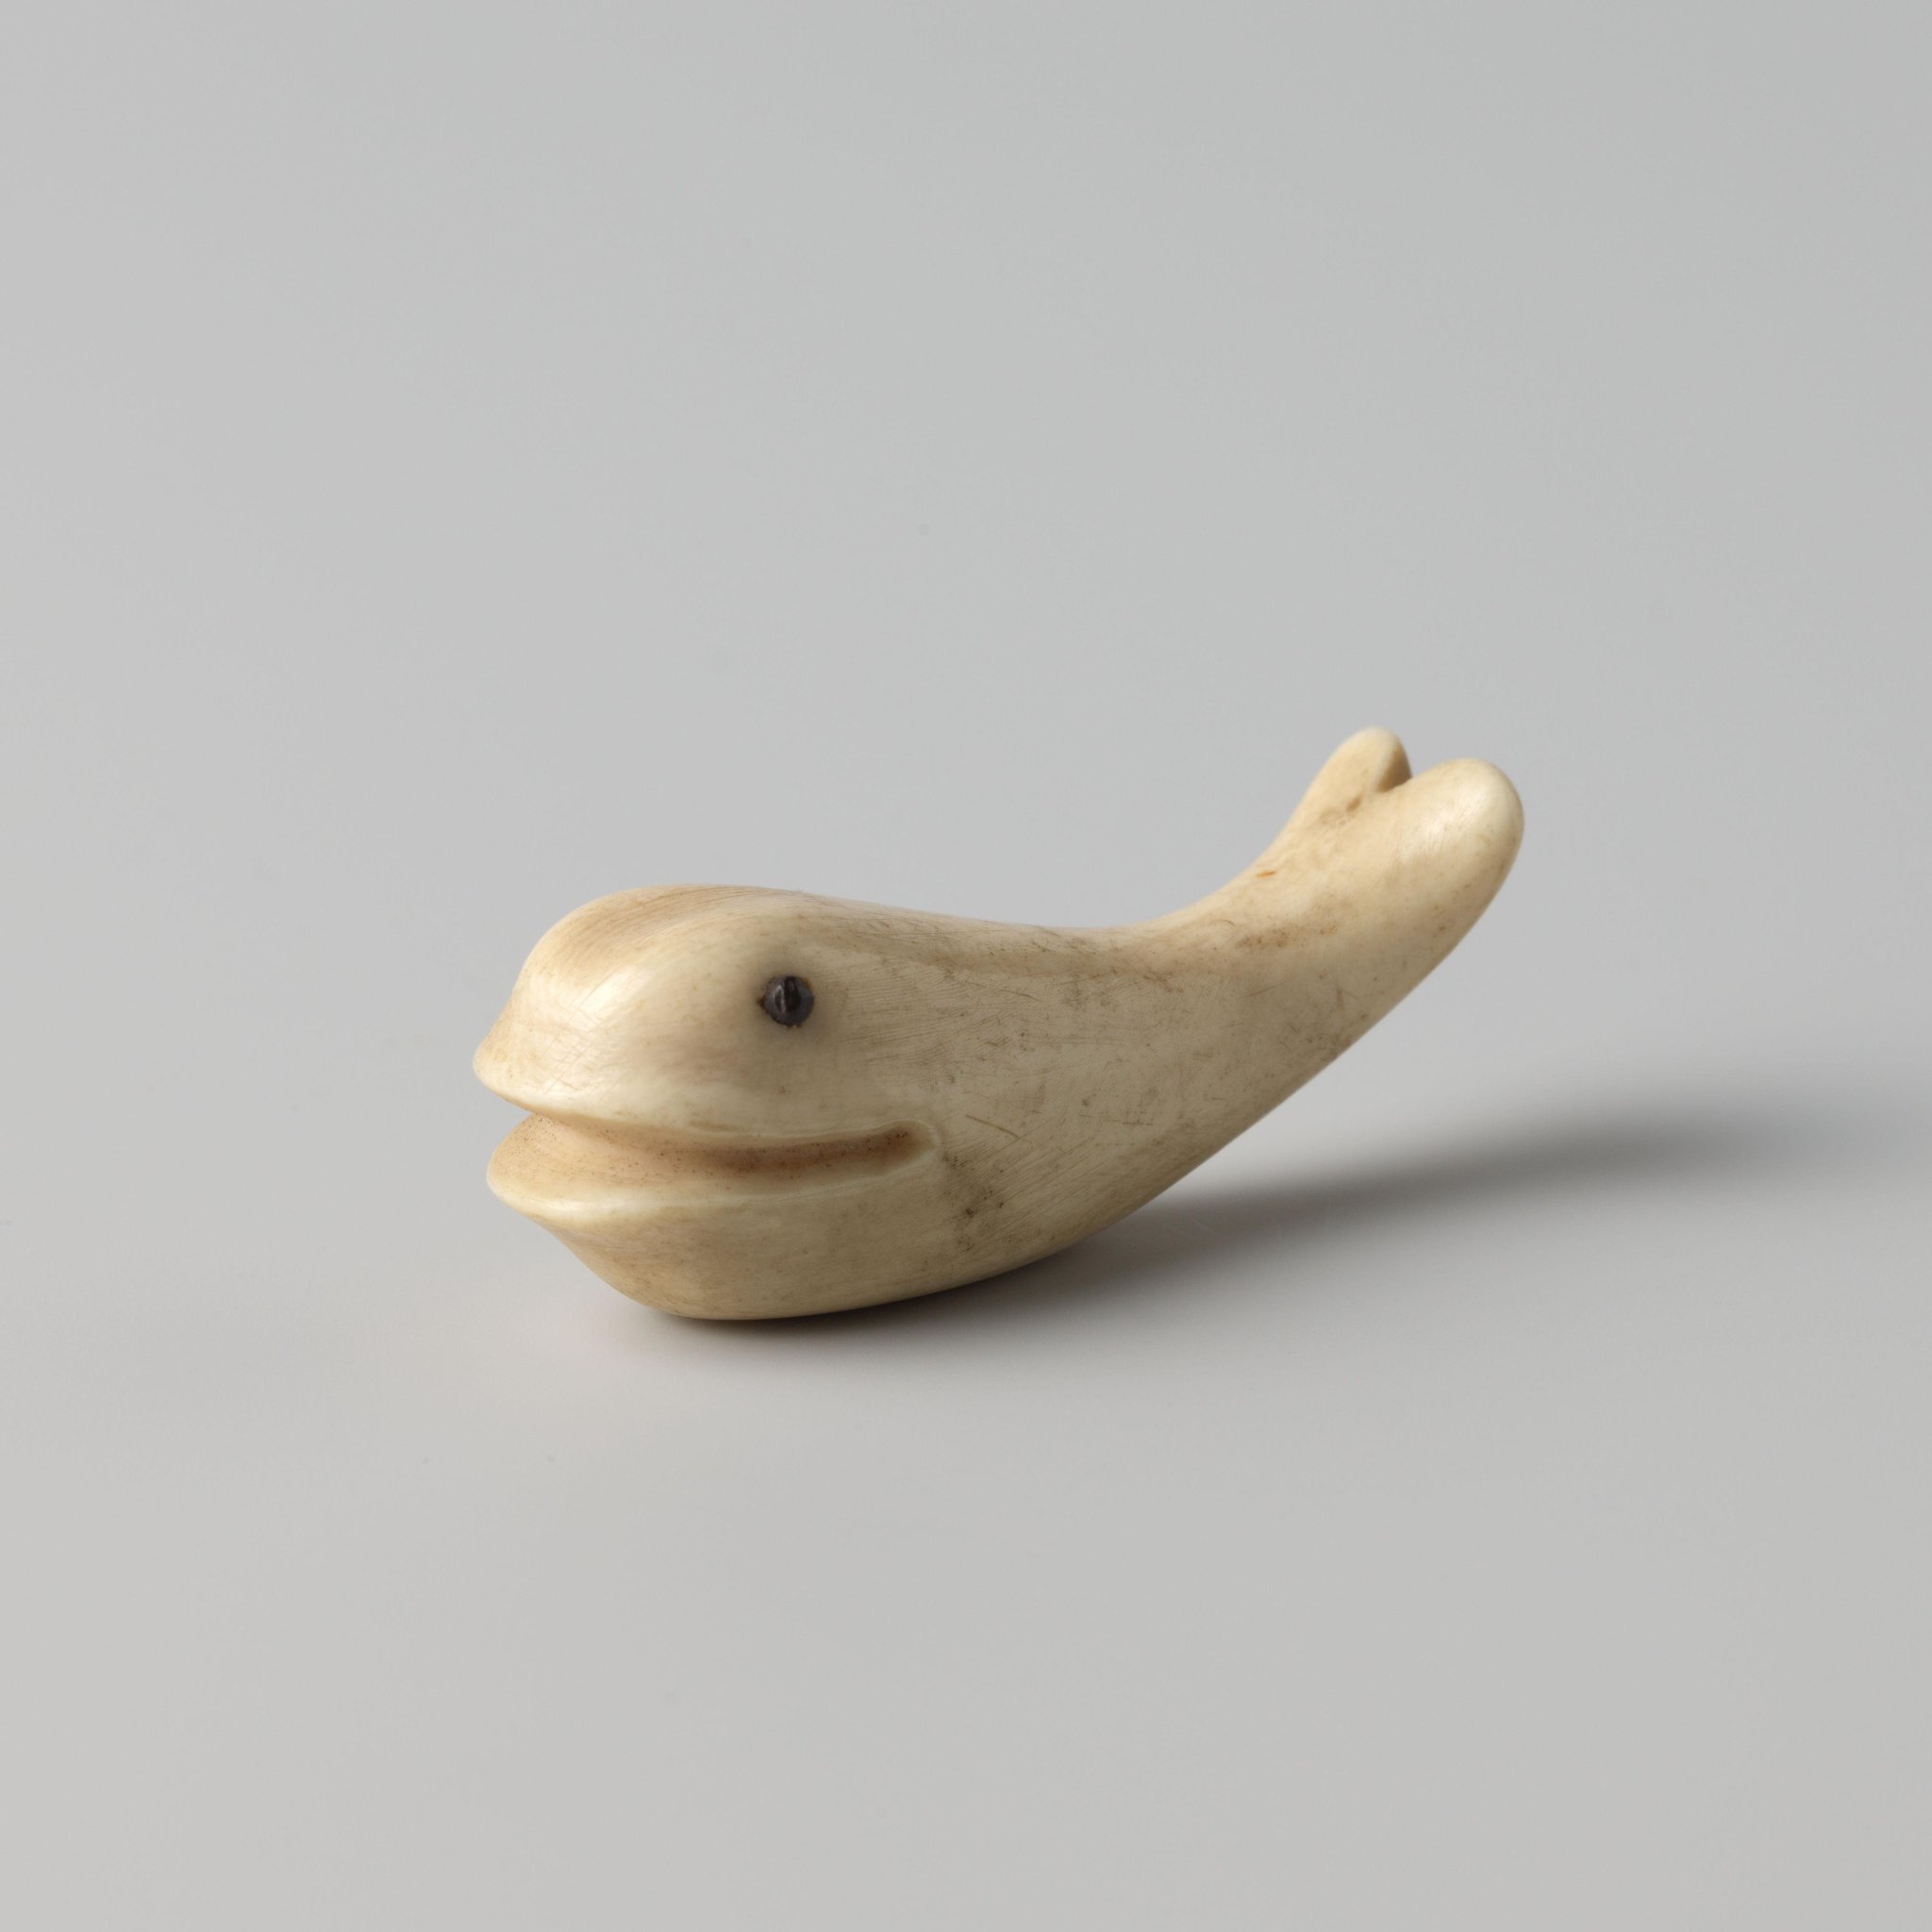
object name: figure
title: Figuur in de vorm van een dolfijn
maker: Anonymous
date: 1700-1900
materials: ivory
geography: china